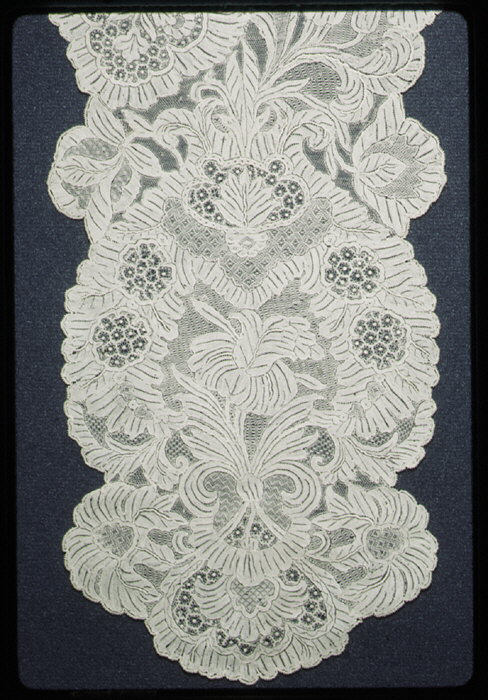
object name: lappet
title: Pair of lappets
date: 1701-1750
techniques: lace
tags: flowers